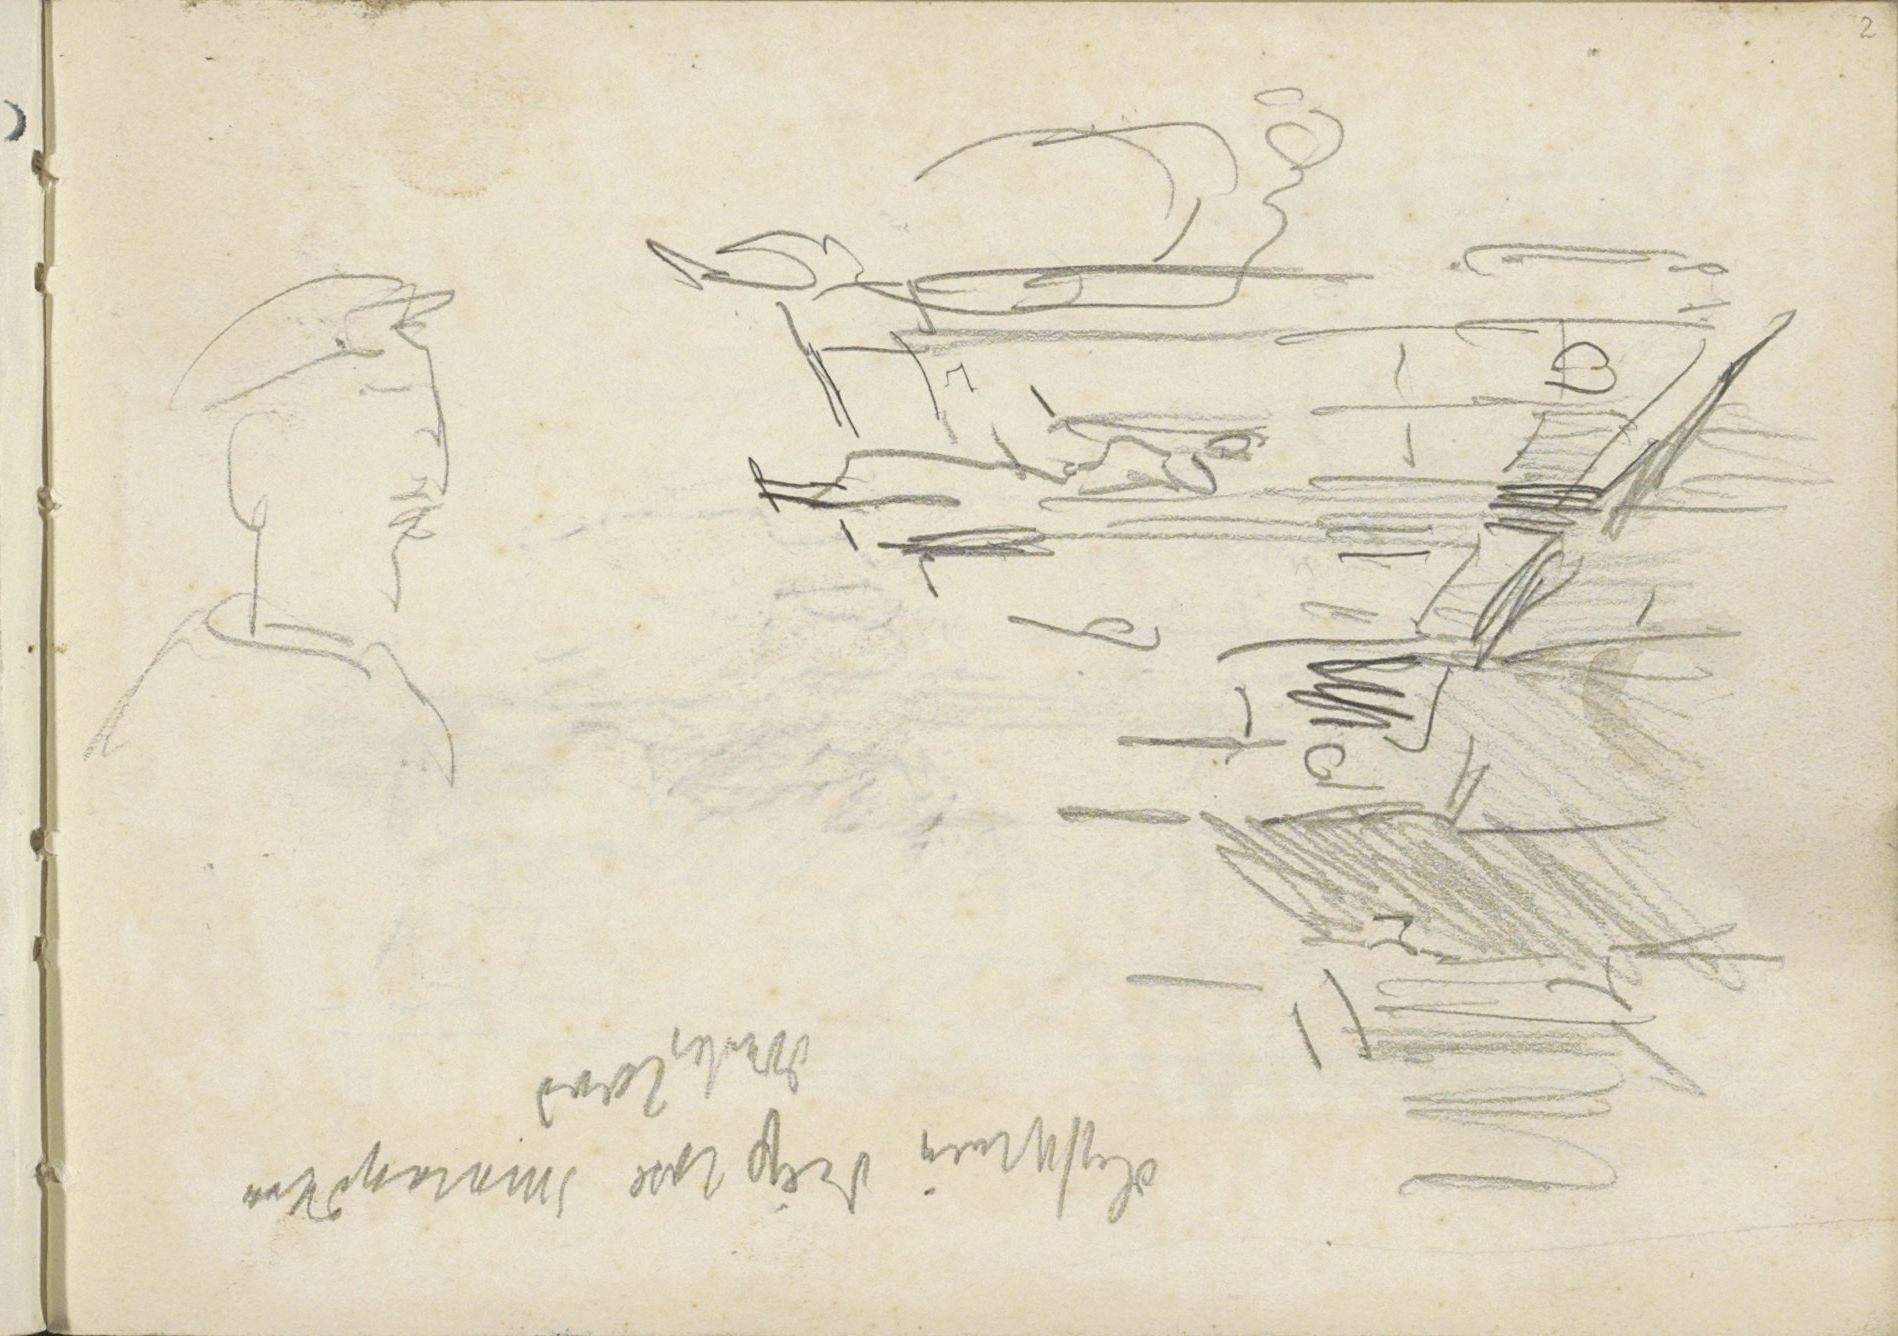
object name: sketchbook leaf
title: Figuren op straat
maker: isaac israels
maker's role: draughtsman, painter, print maker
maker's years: 1865-1934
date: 1930-1934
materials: paper, pencil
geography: the hague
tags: head (human), street (+ city(-scape) with figures, staffage)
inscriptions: : ‘olijfgroen diep rose smaragdgroen / donkerrood’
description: Pagina 2 uit schetsboek XXXVIII met 45 pagina's.